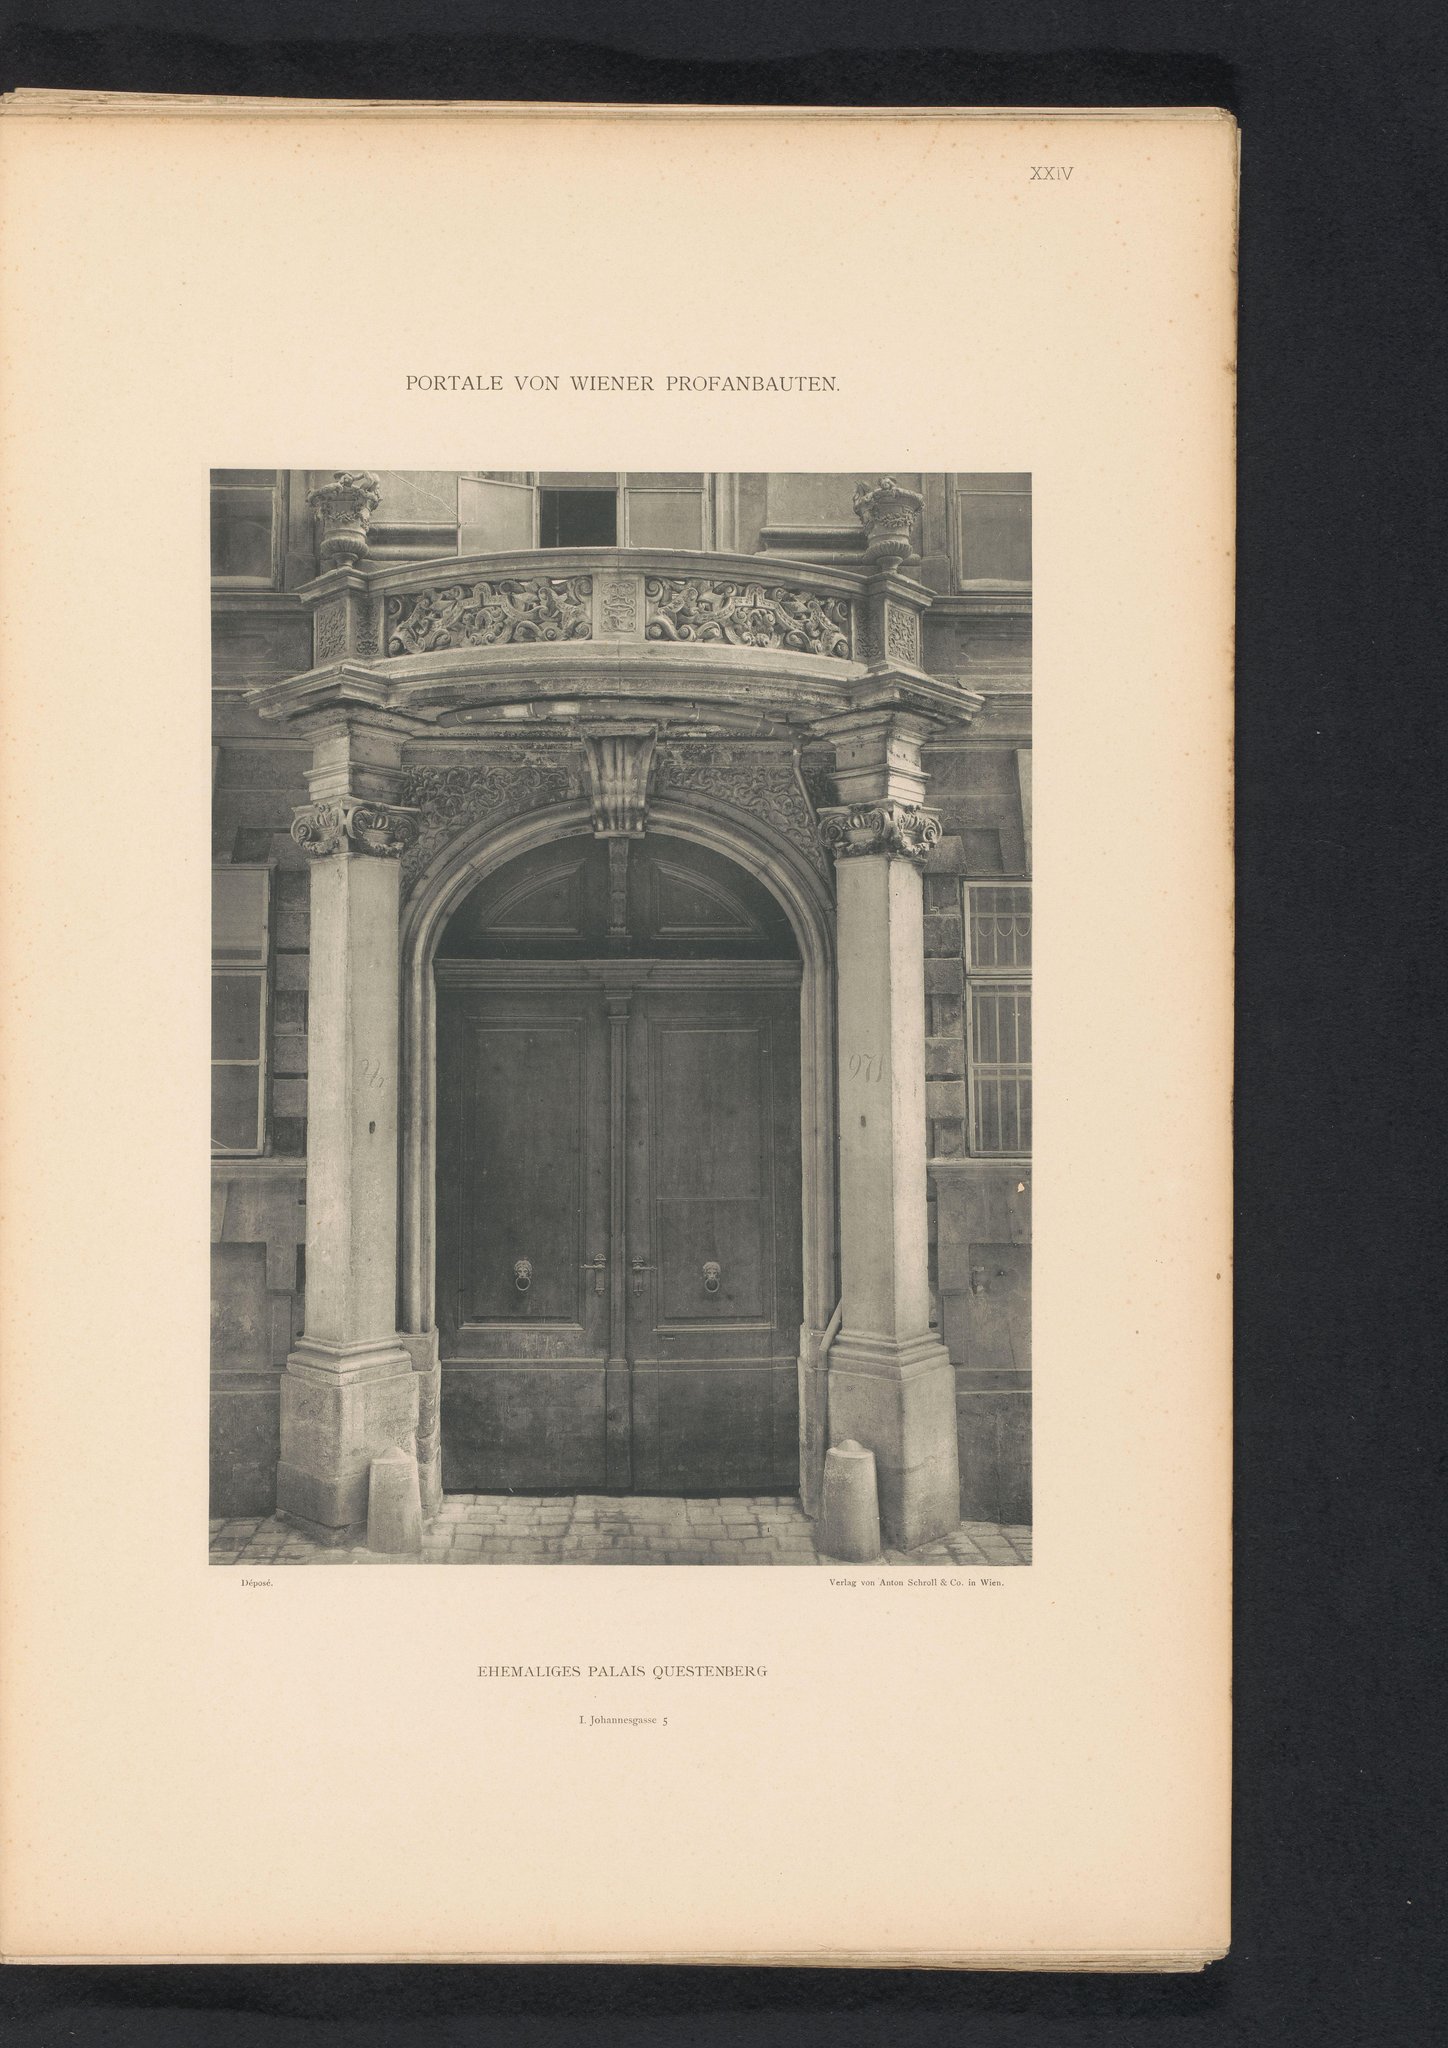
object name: page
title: Ehemaliges Palais Questenberg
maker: Anonymous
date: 1884-1894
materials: paper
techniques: photograph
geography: austria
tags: gate, entrance, façade (of house or building)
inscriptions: inscription: ‘I. Johannesgasse 5’, number: ‘XXIV.’